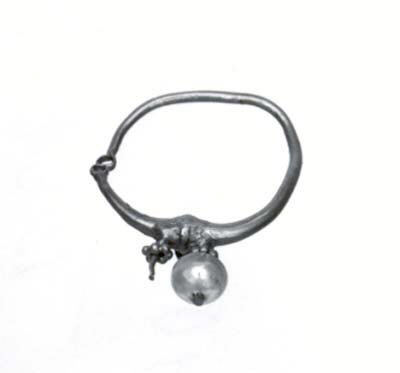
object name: earring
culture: sasanian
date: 201-700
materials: gold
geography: iran